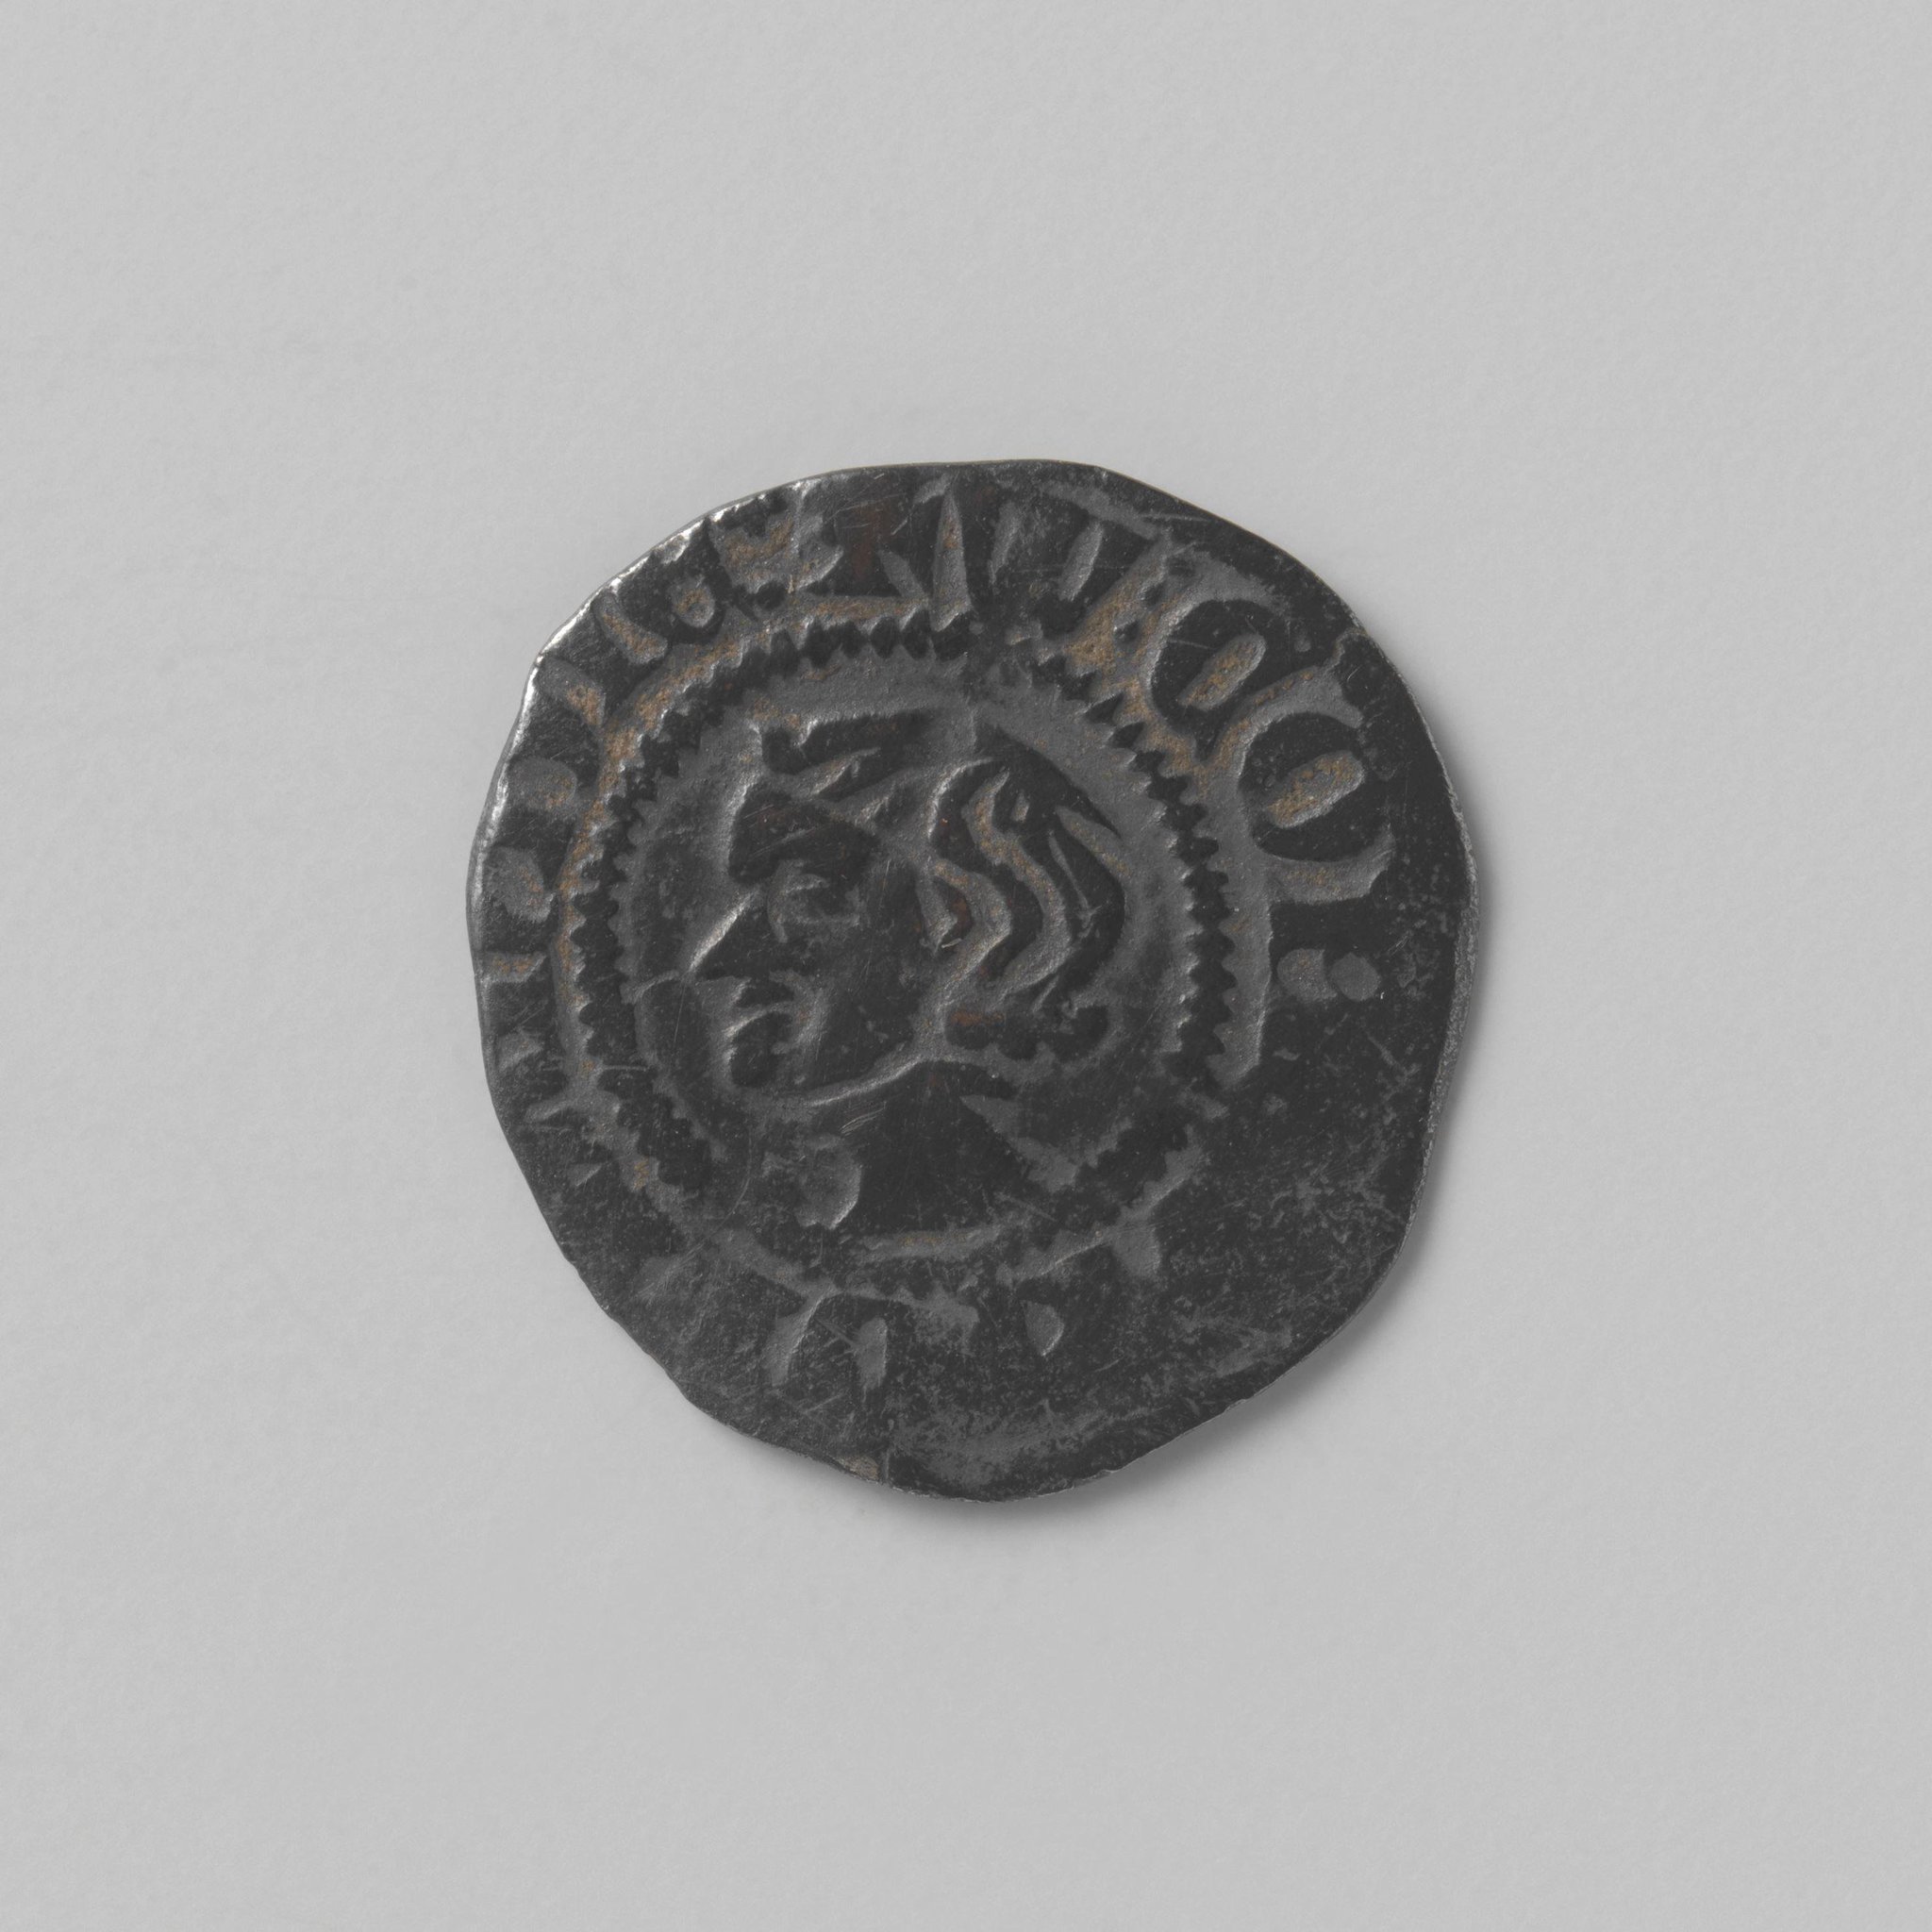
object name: penny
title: Holland, Willerm III, penning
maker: willem iii de goede (graaf van holland en henegouwen)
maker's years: 1285-1337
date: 1304-1305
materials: silver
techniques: striking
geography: dordrecht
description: Zilveren munt. Voorzijde: hoofd naar links. Keerzijde: lang gevoet kruis.